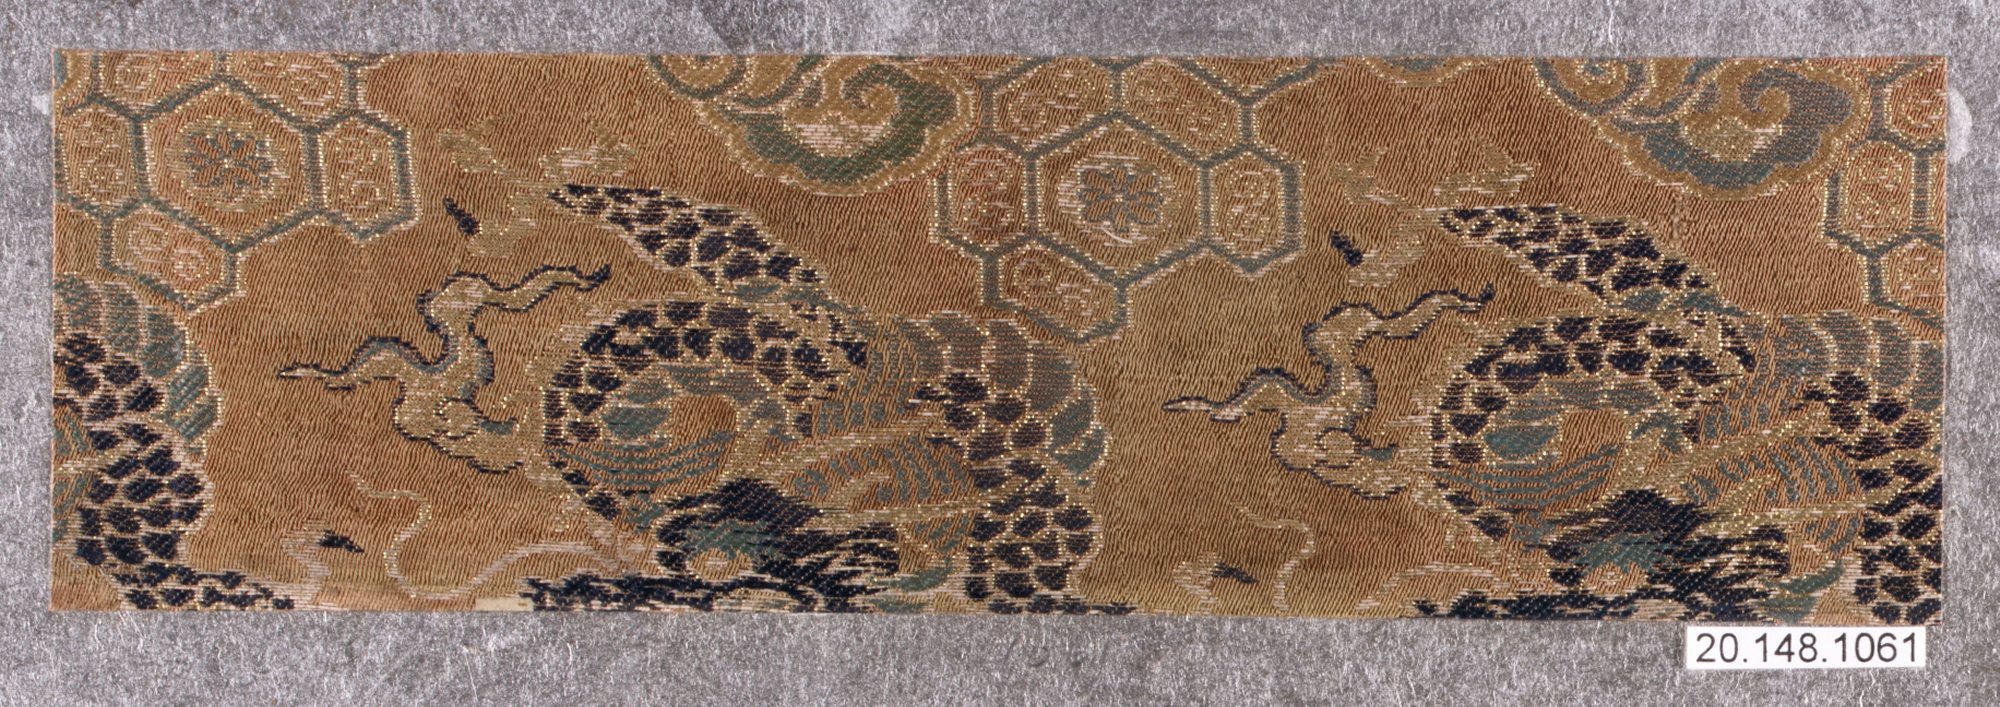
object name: piece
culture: chinese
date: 1701-1800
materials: silk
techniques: compound weave